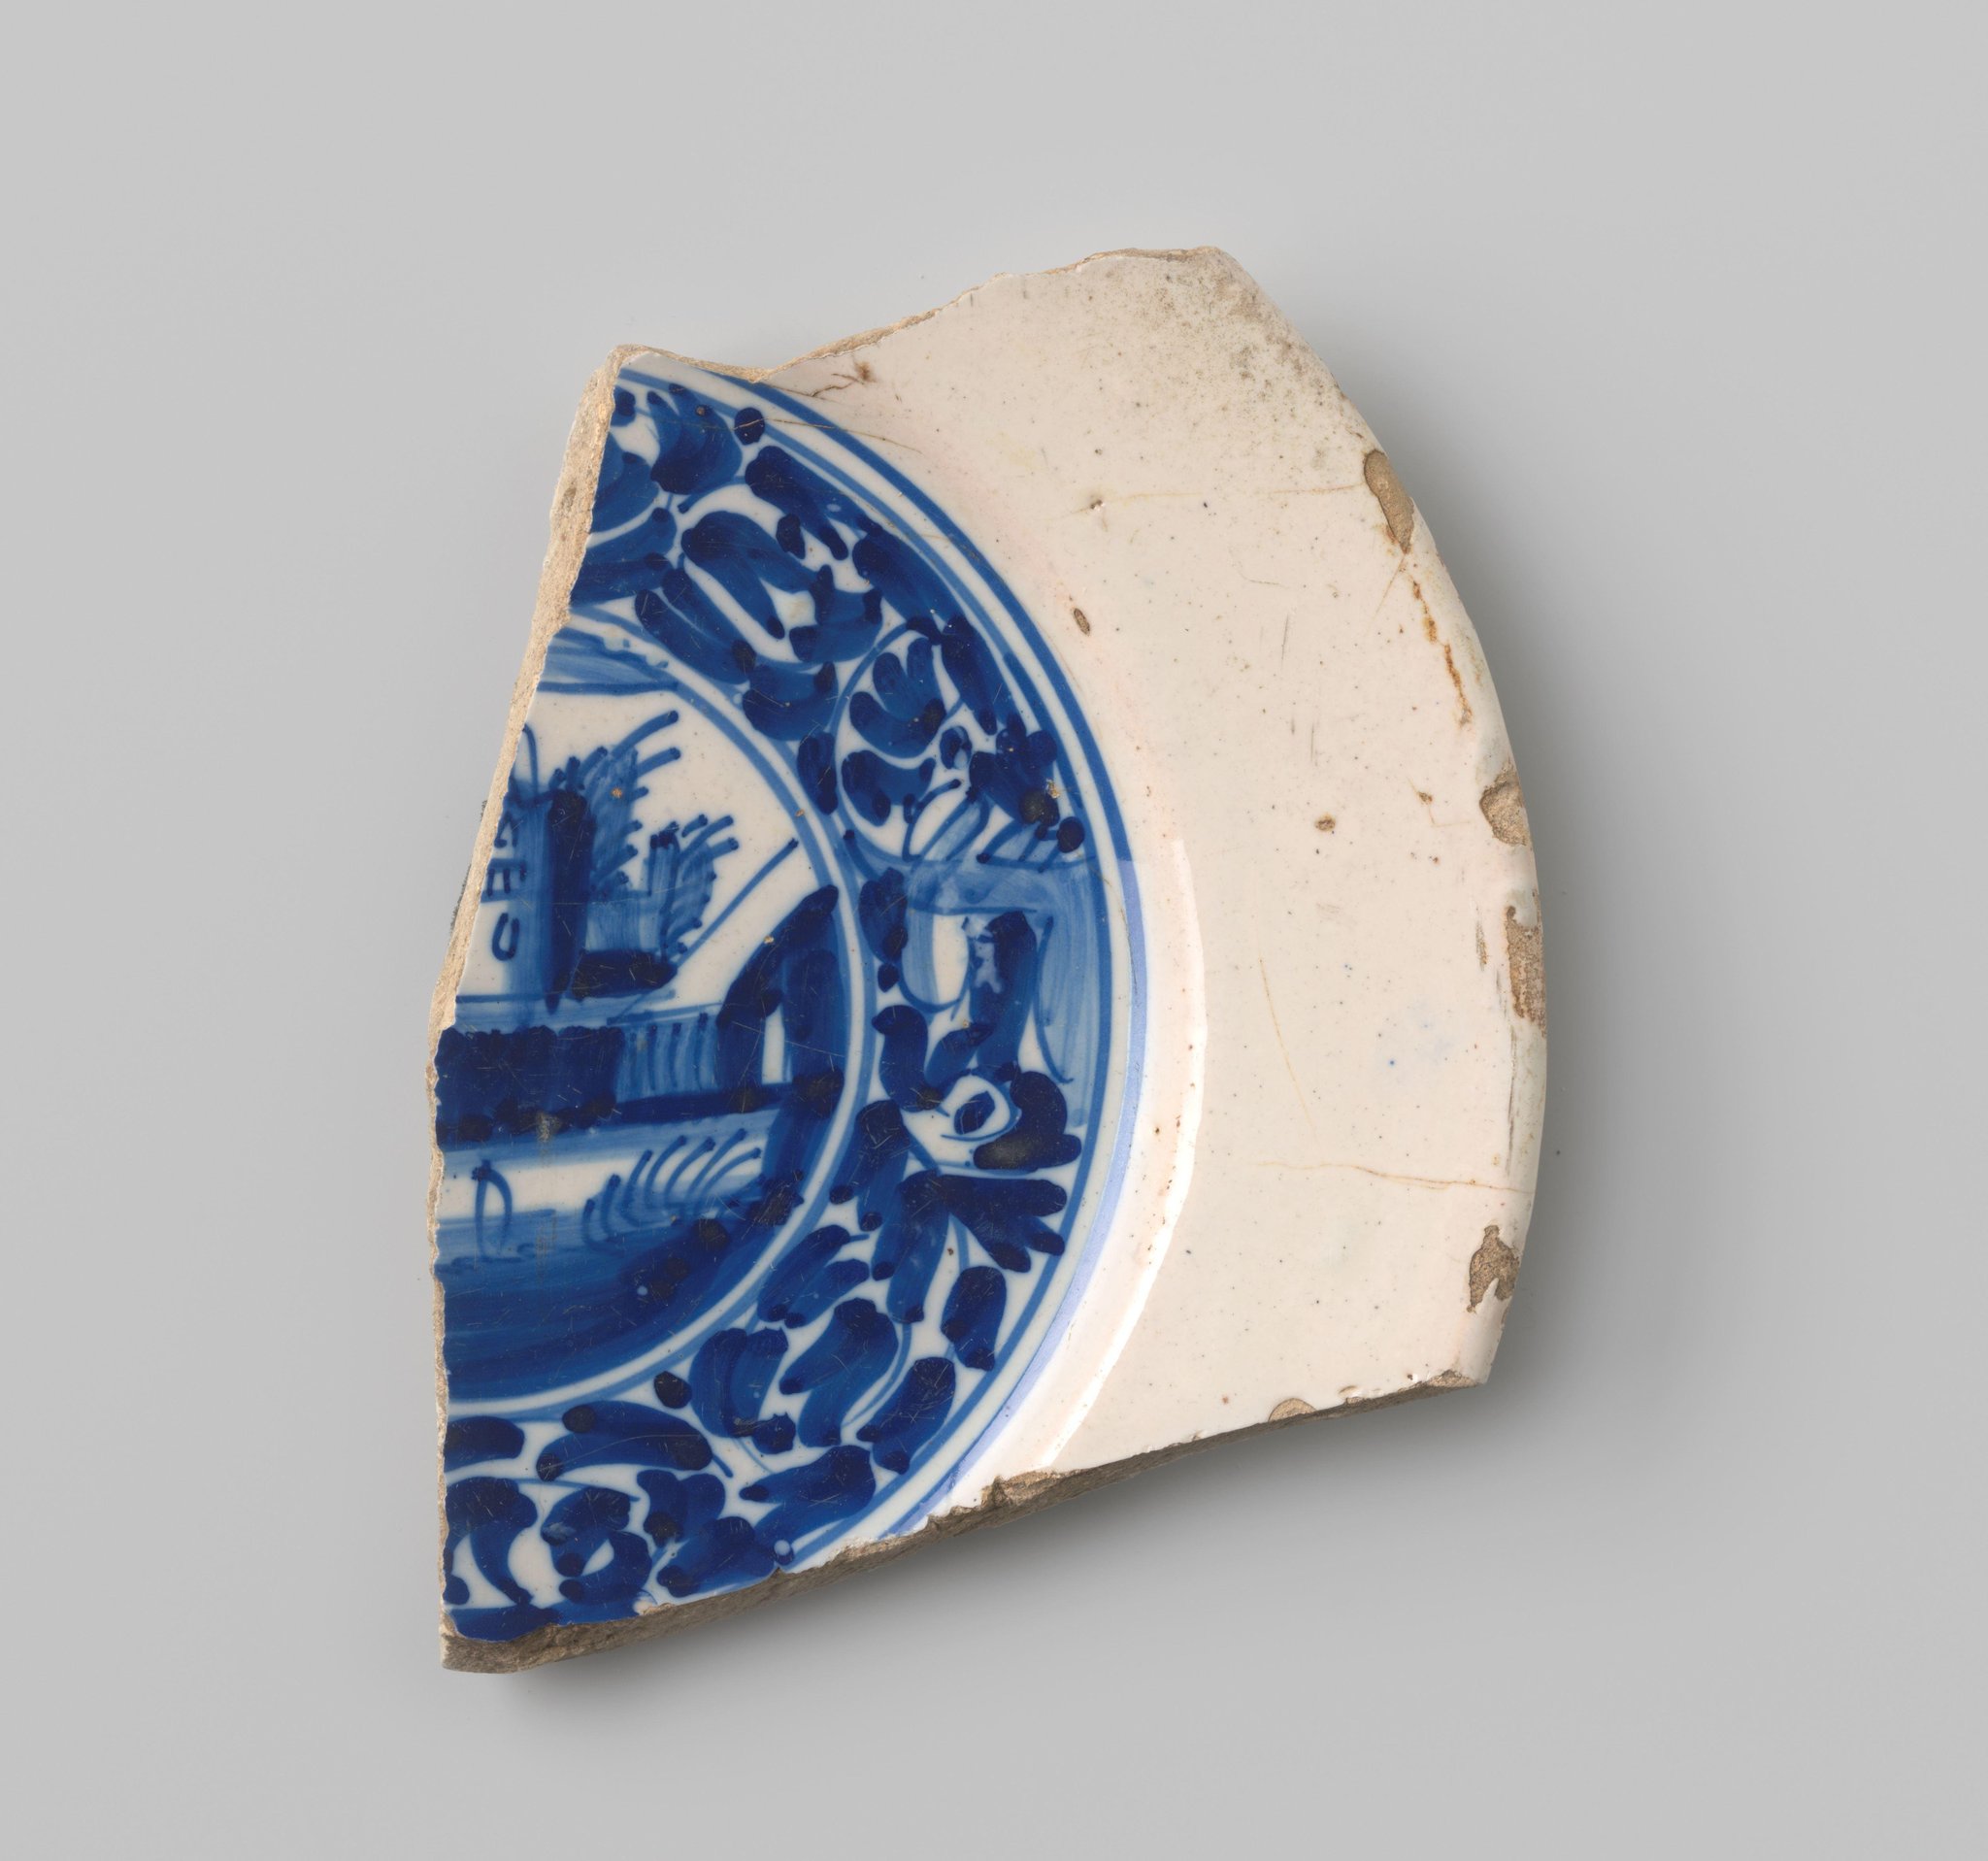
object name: fragment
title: Schotelscherf van witbakkend aardewerk, voorzien van wit glazuur aan de boven- en onderzijde, waarbij op de bovenzijde de resten van een omrande voorstelling van een landschap met bebouwing in blauw te zien zijn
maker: Anonymous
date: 1500-1699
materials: earthenware, glaze